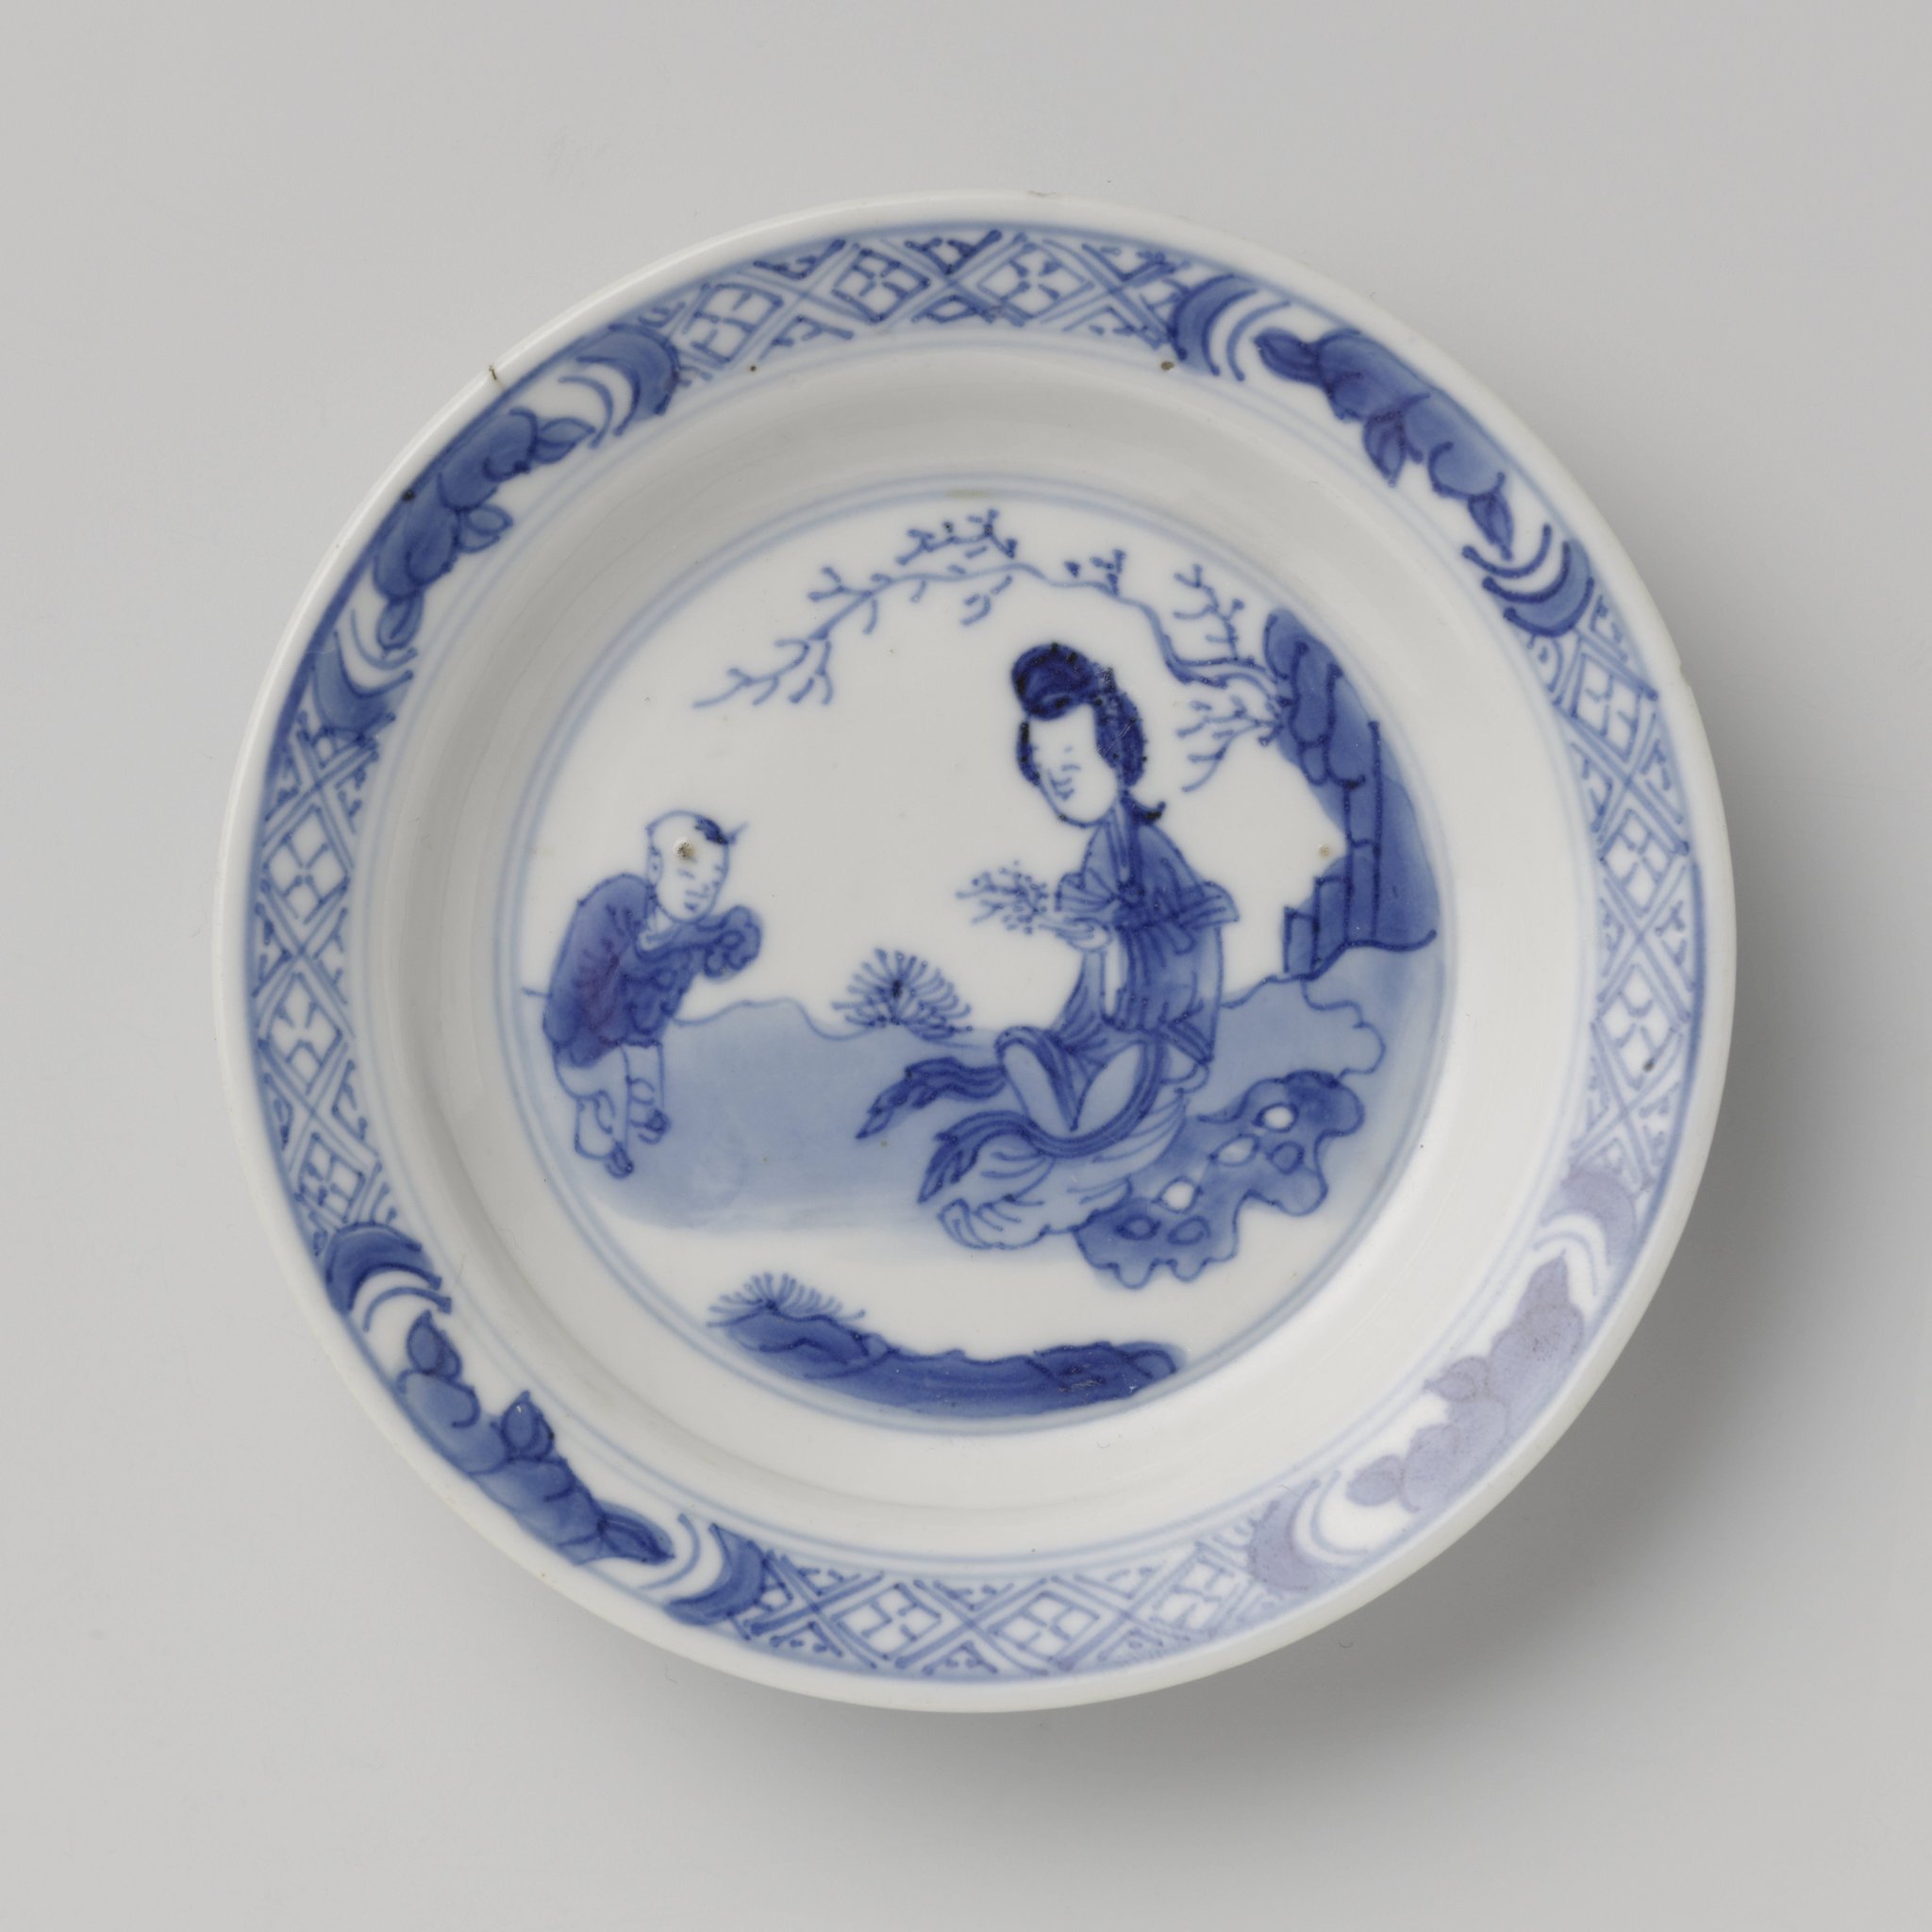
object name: platter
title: Two lidded pots and a saucer depicting women and boys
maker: Anonymous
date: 1680-1720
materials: cobalt, glaze, paint, porcelain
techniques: firing, turning, vitrification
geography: china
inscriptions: mark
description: Schotel van porselein. De schotel heeft op de rand een versiering van vier medaillons met bladmotieven gescheiden door ruitvormen, waarin een vierbladig rozet. Op het plat een vrouw zittend in een tuin onder een dunne boomtak, links voor haar staat een kind. Op de buitenrand vier van de waardevolle voorwerpen: een paar boeken, een tekening, een juweel en een artemisiablad. De schotel is gemerkt.